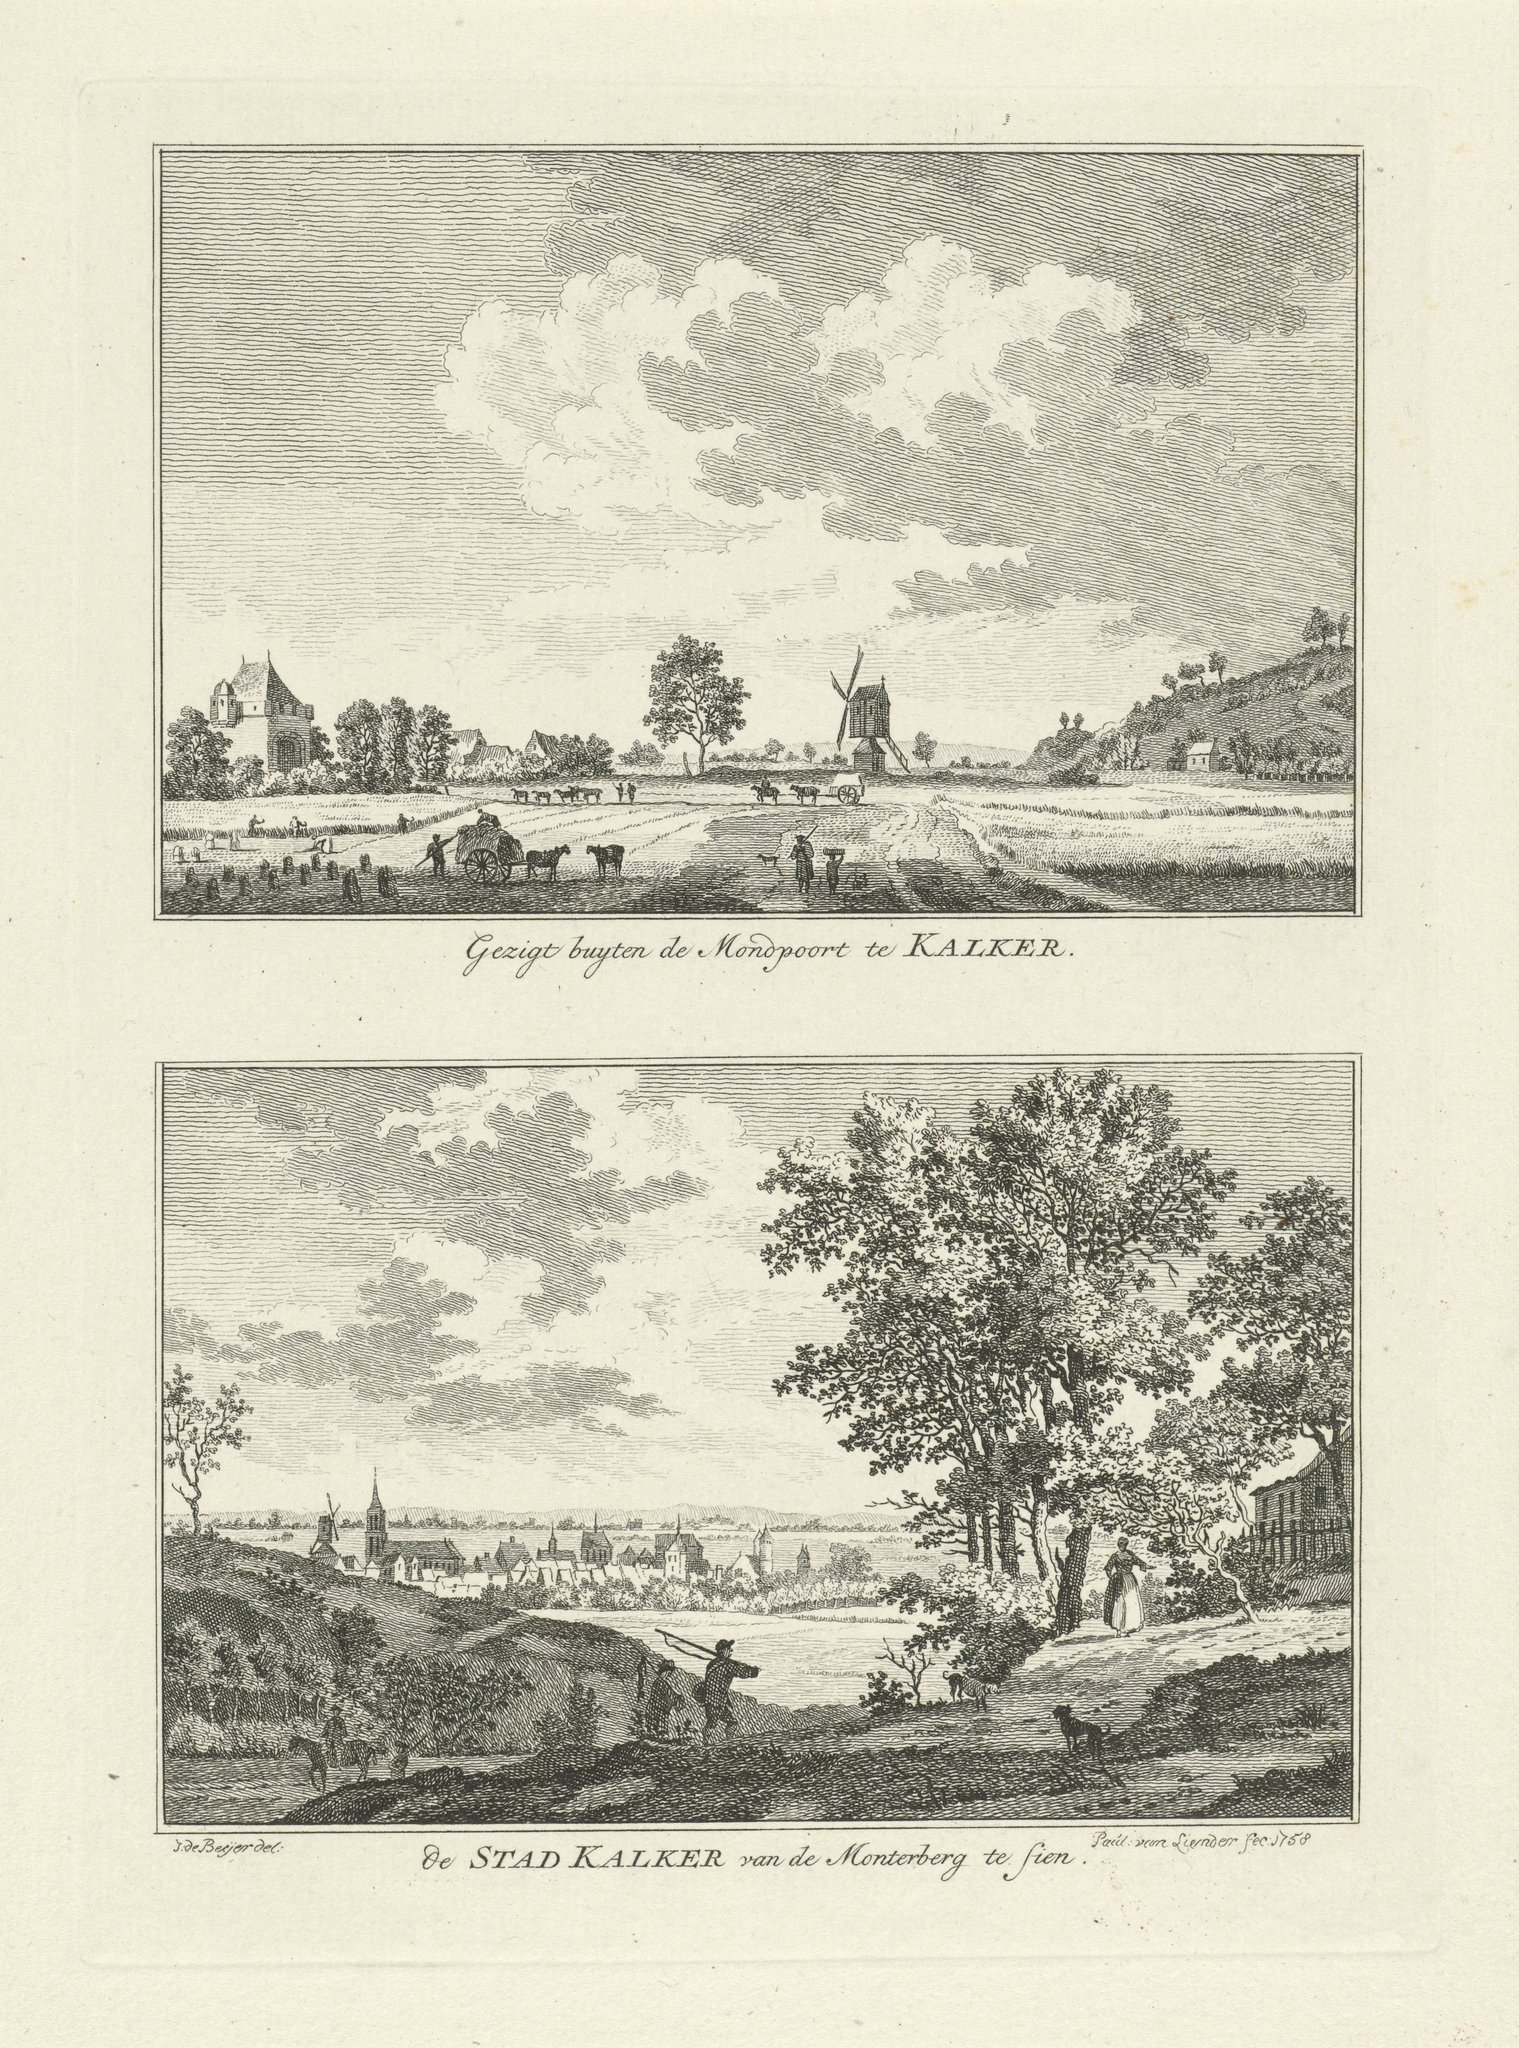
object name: print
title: Gezigt buyten de Mondpoort te Kalker/ De Stad Kalker van de Monterberg te sien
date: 1758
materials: paper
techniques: etching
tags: landscapes in the temperate zone, prospect of city, town panorama, silhouette of city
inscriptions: collector's mark: Lugt 240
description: Twee voorstellingen van één plaat. Gezichten op het platteland buiten de Montpoort van de Duitse stad Kalkar (boven) en gezicht op de stad Kalkar vanaf de Monterberg (onder). De prent maakt deel uit van een 100-delige serie met gezichten op dorpen en steden te Kleef.